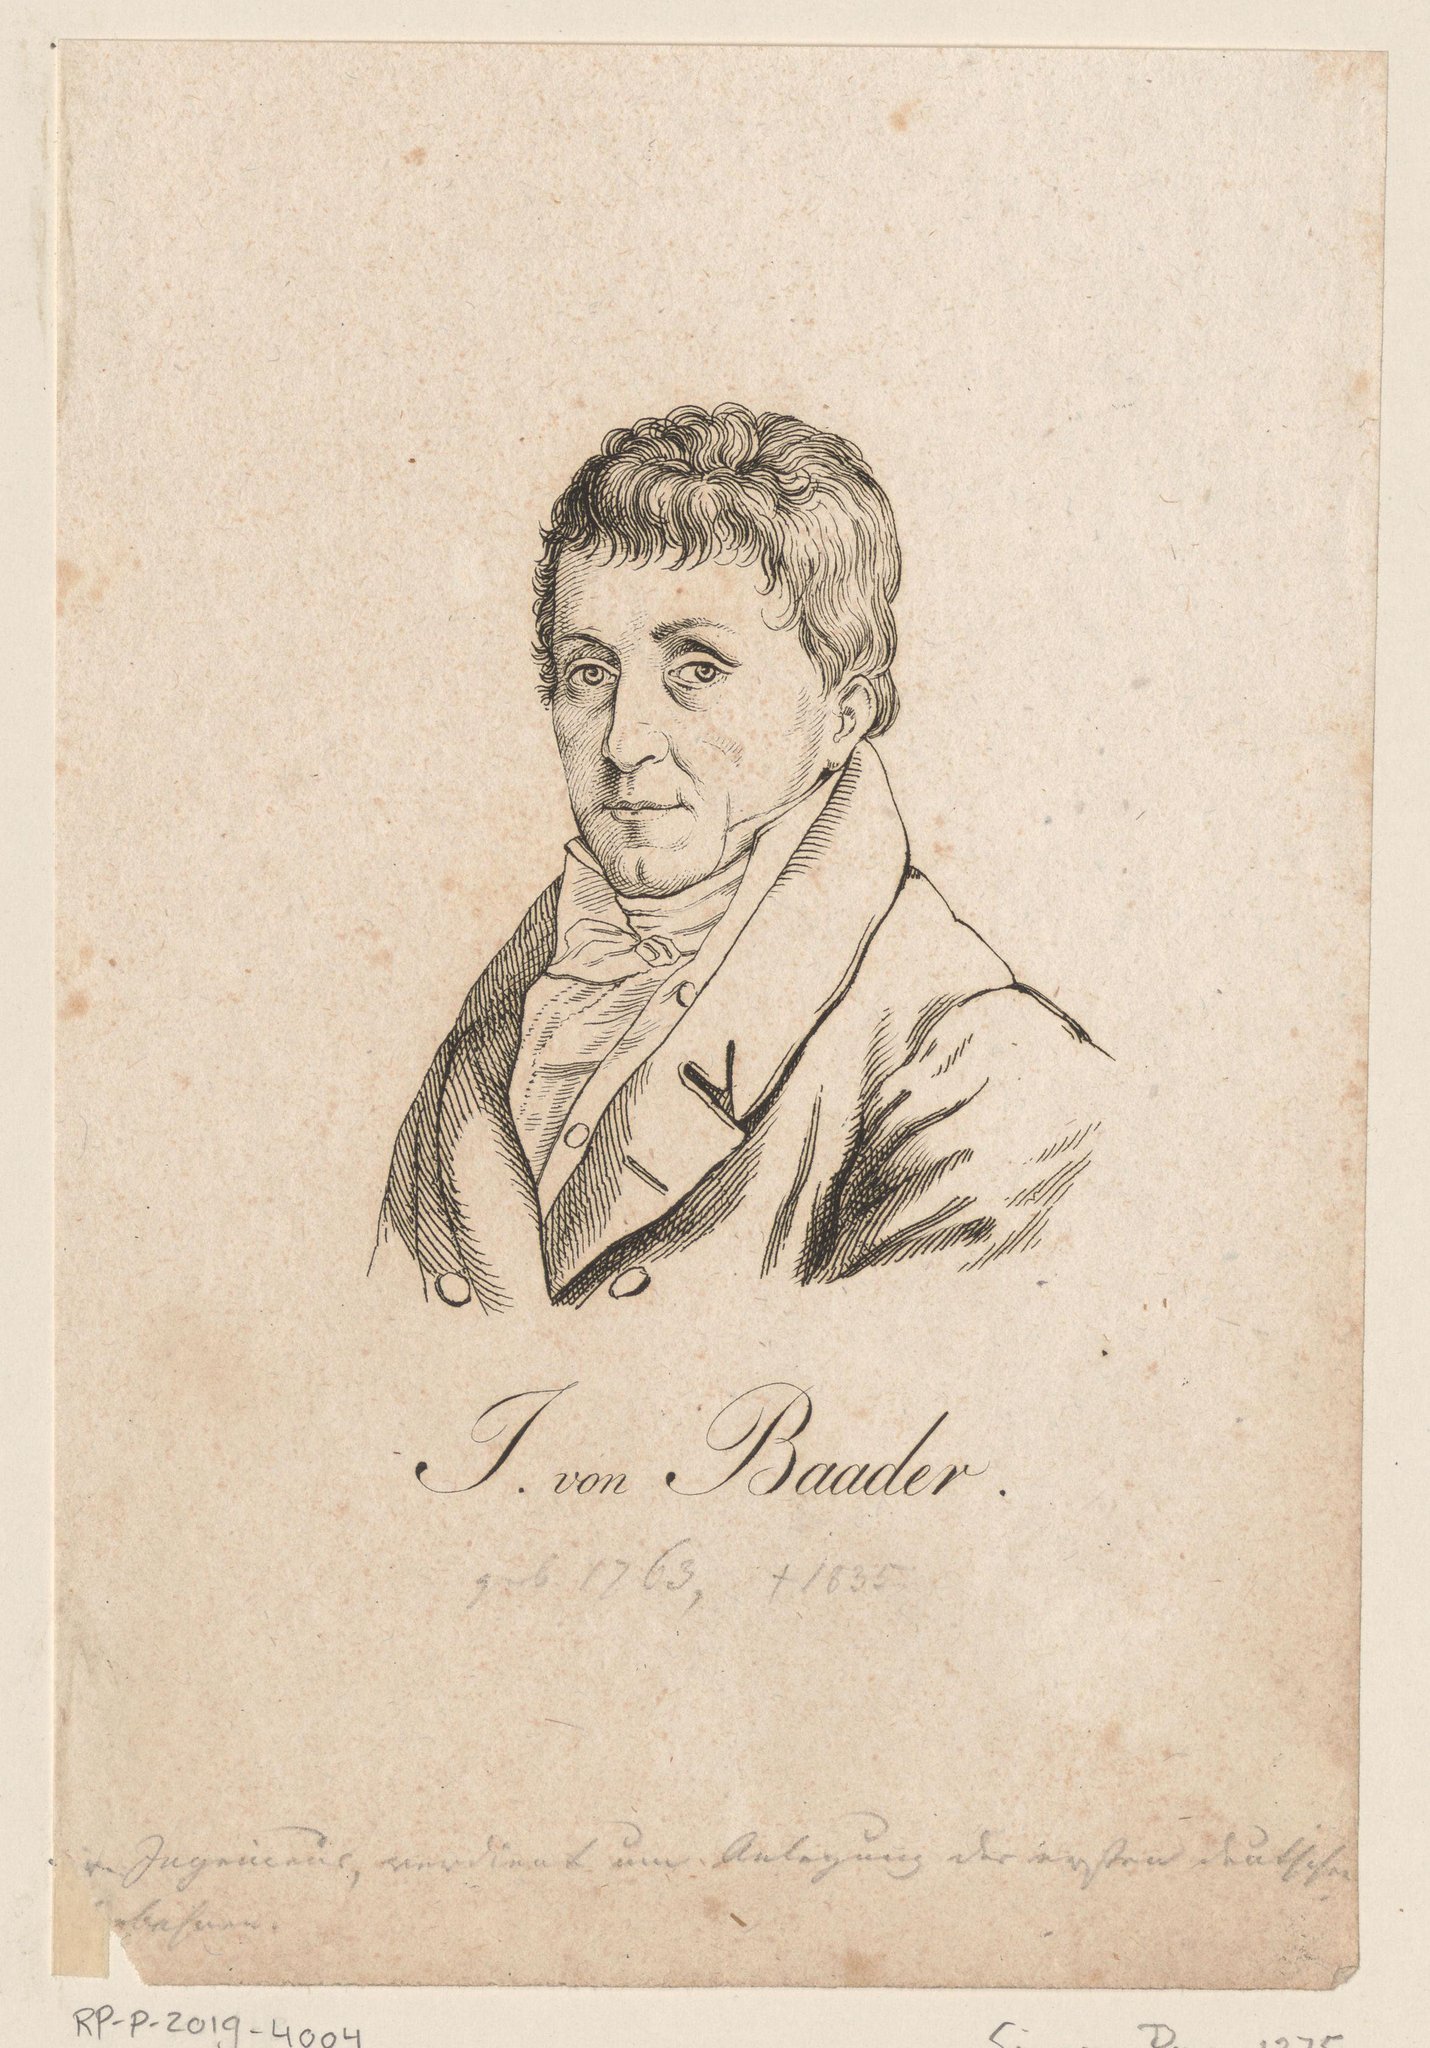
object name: print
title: Portret van Joseph von Baader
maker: Anonymous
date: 1800-1849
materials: paper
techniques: etching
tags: historical persons